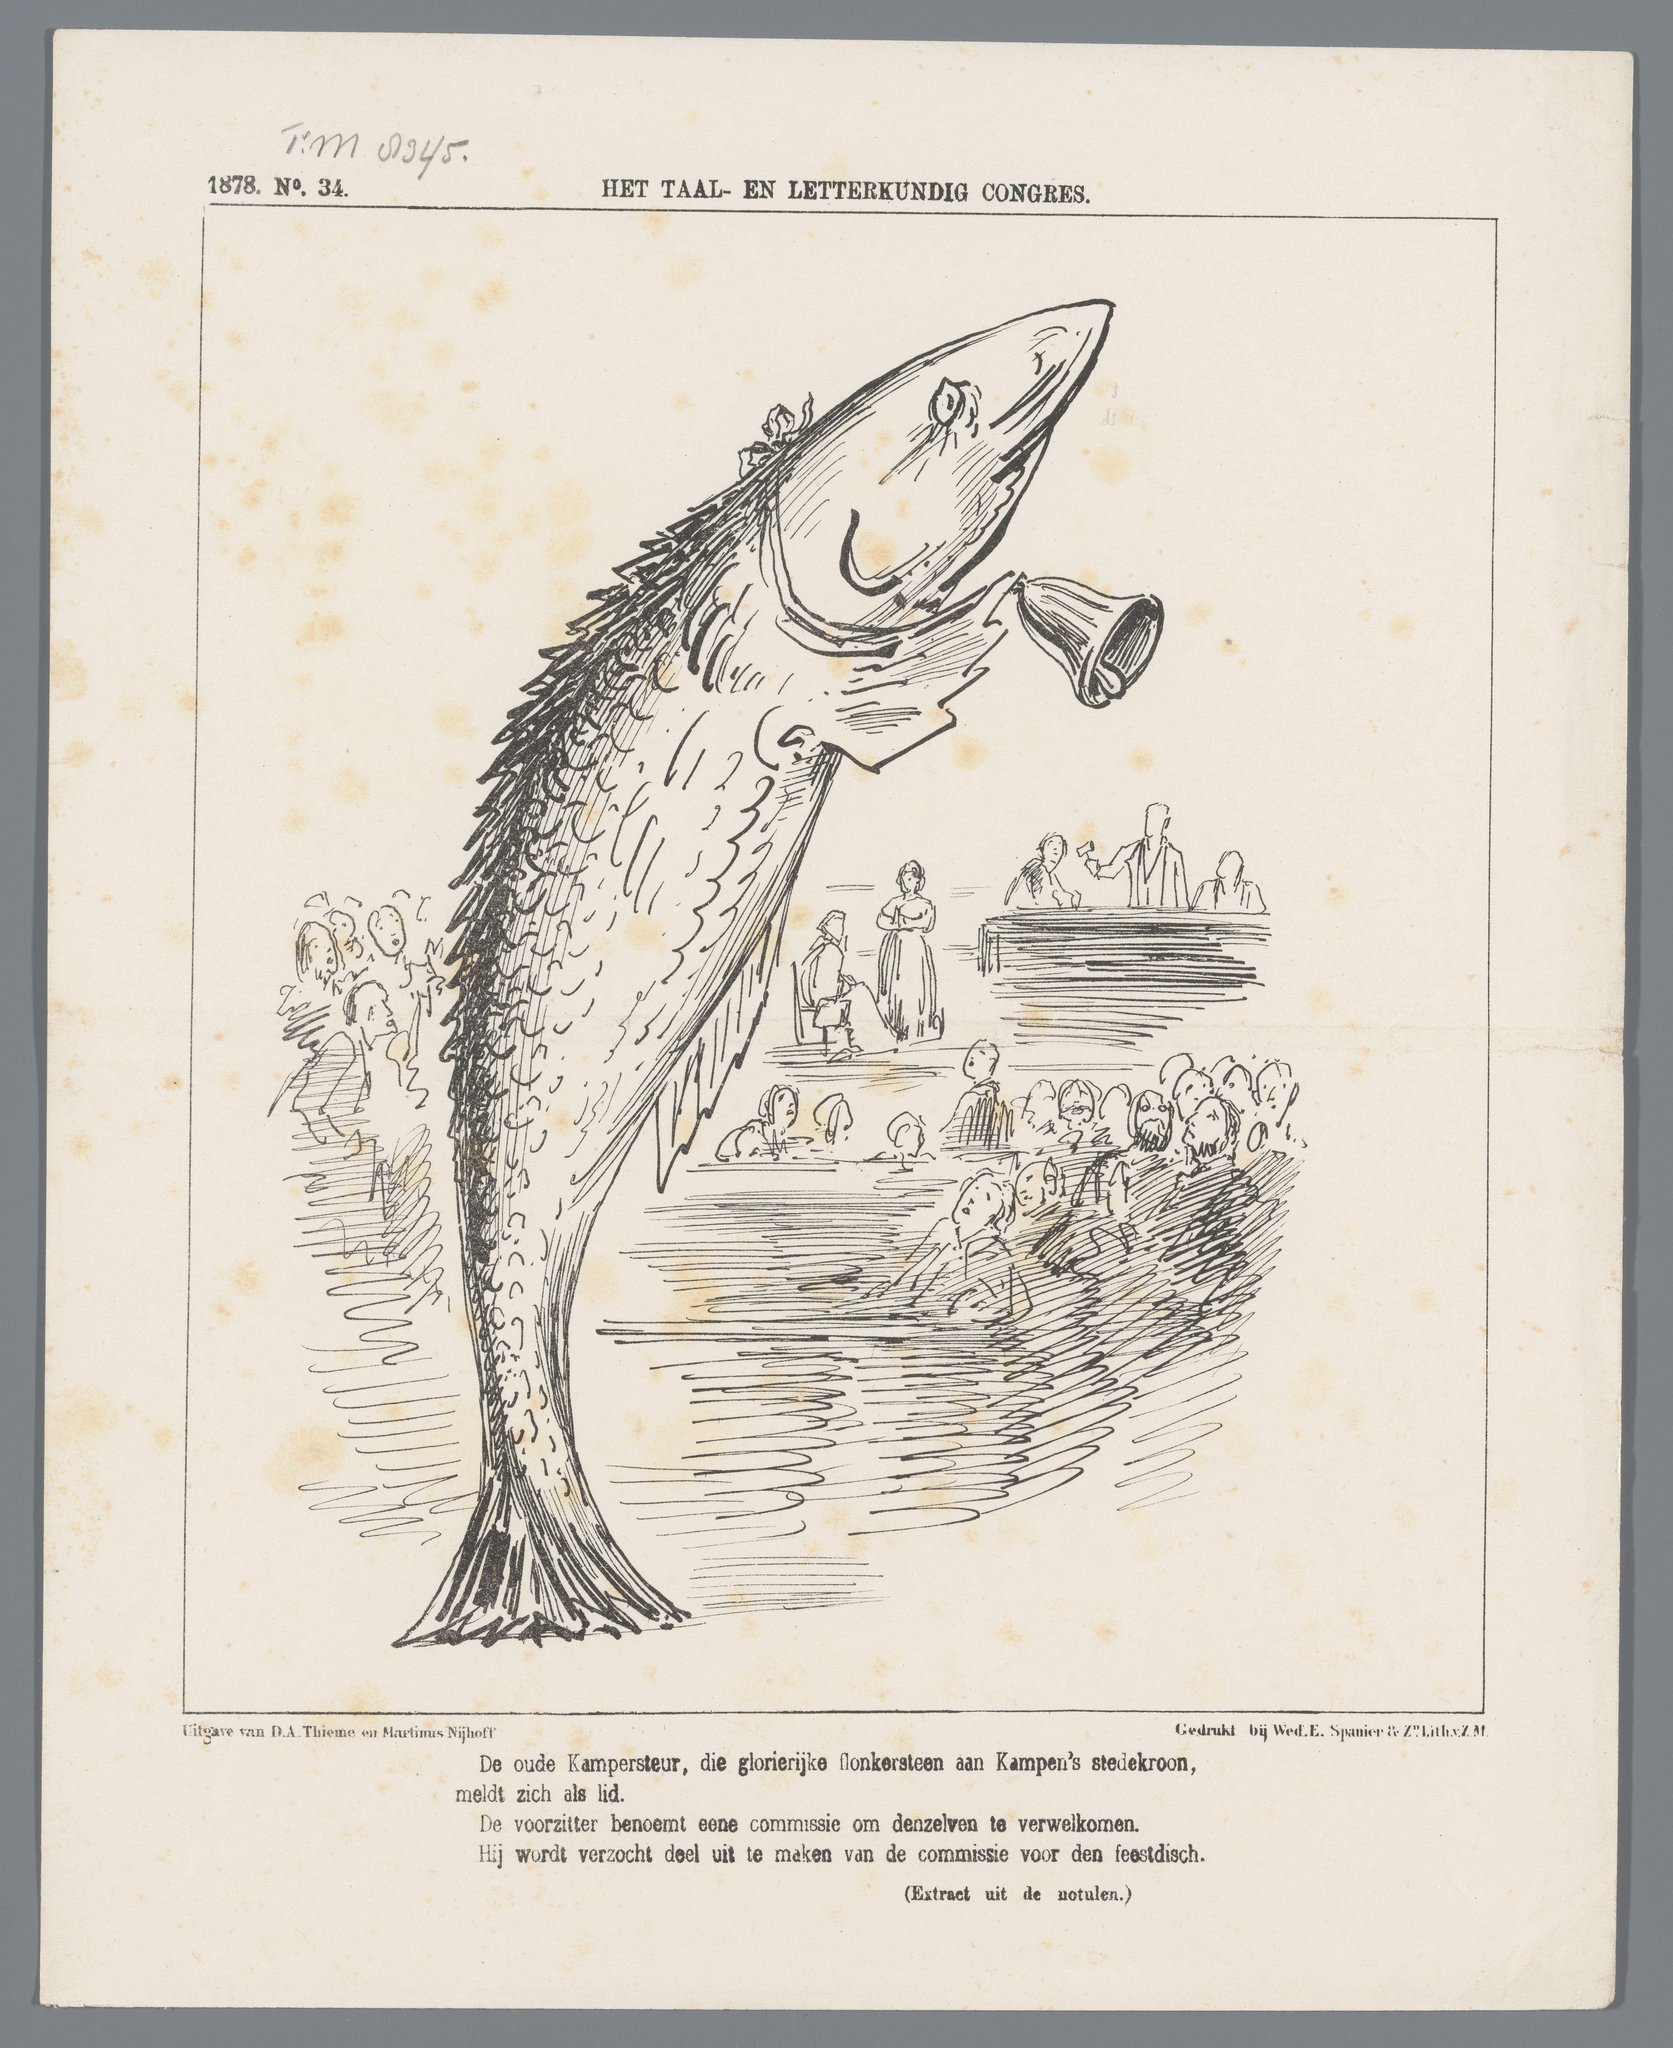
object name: cartoon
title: Spotprent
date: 1878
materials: paper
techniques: lithograph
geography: arnhem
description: Spotprent. Plaat verschenen bij het weekblad De Nederlandsche Spectator, nr. 34, 1878.